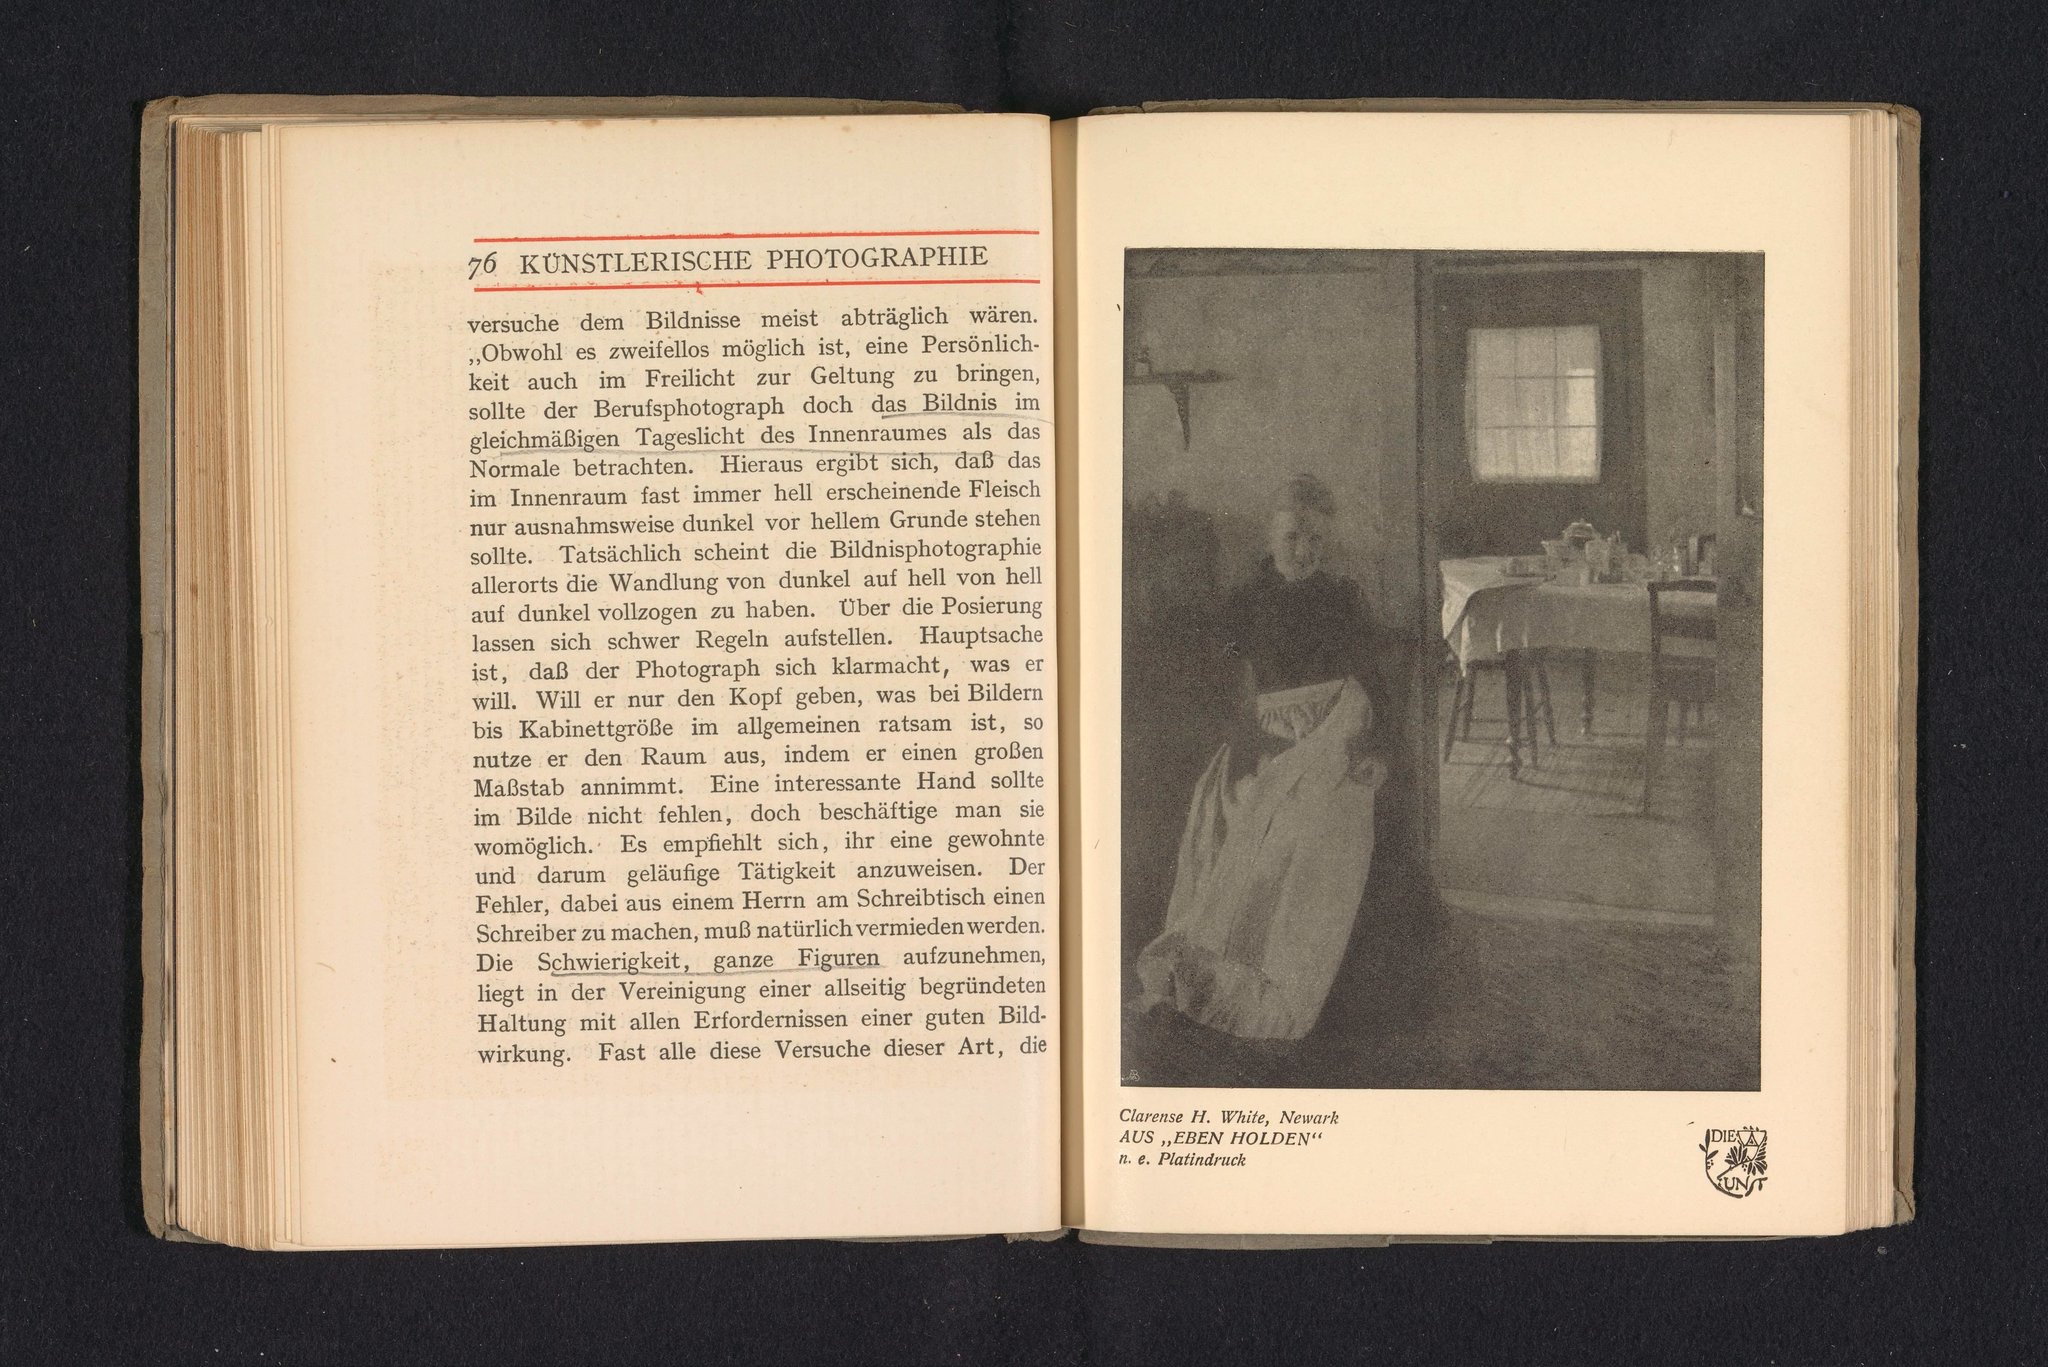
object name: page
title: Fotoreproductie van een foto door Clarence Hudson White, voorstellend een interieur van een huis met een vrouw op een stoel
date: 1880-1907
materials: paper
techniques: autotype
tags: interior of the house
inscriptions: inscription: ‘n.e. Platindruck’